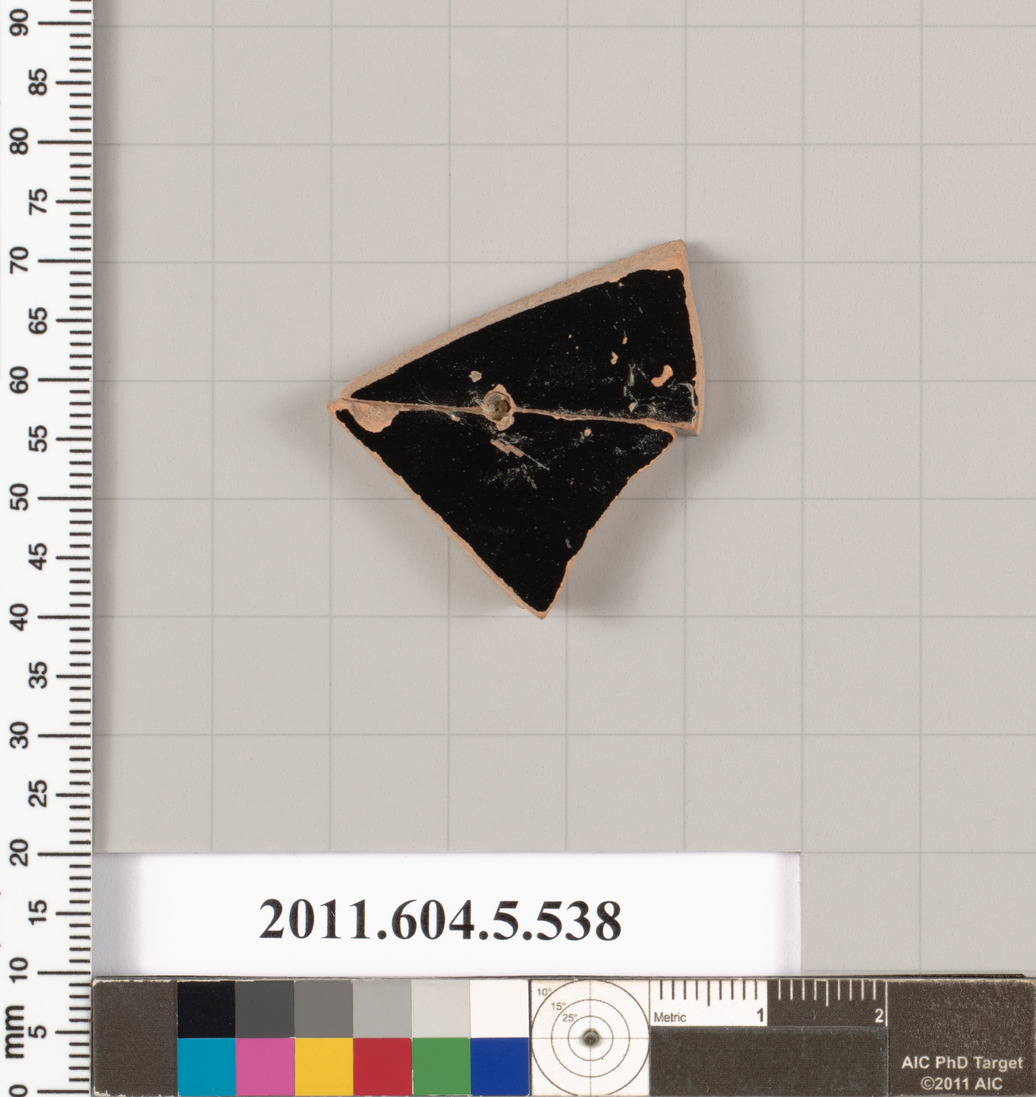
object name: kylix fragment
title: Terracotta fragment of a kylix (drinking cup)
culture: greek, attic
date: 600-401 BCE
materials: terracotta